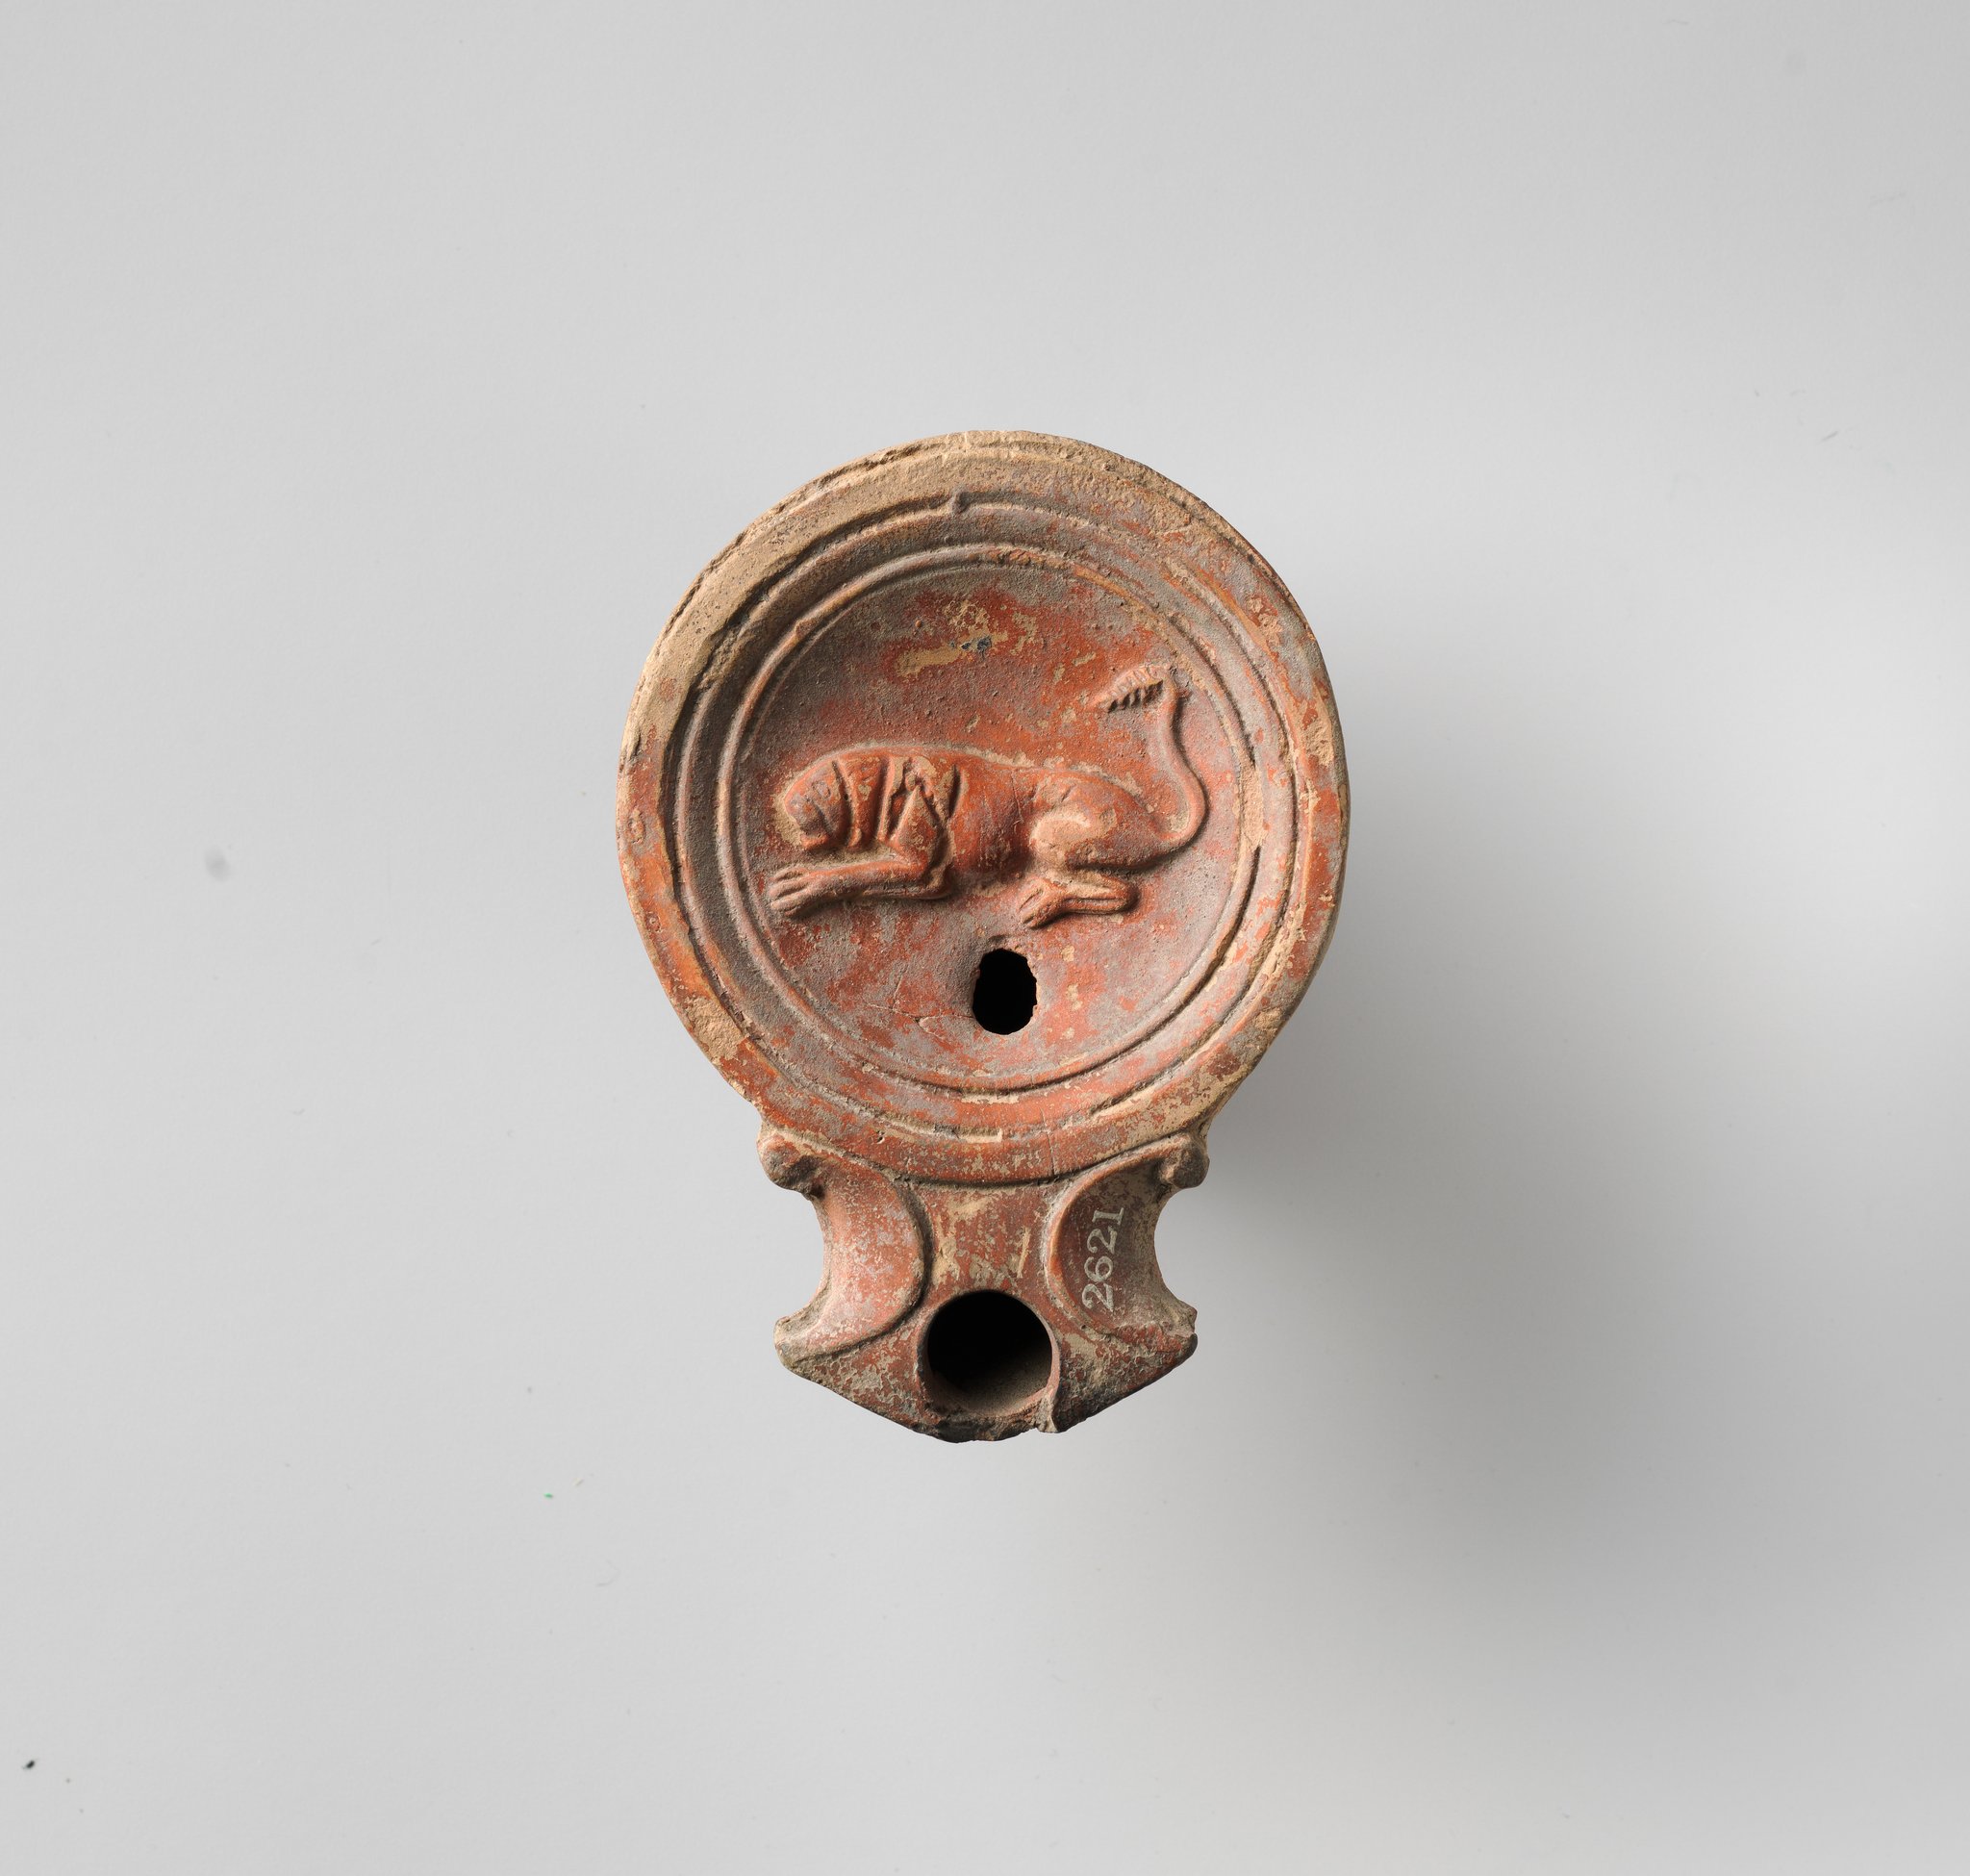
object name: lamp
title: Terracotta oil lamp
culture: roman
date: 40-100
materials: terracotta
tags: lions